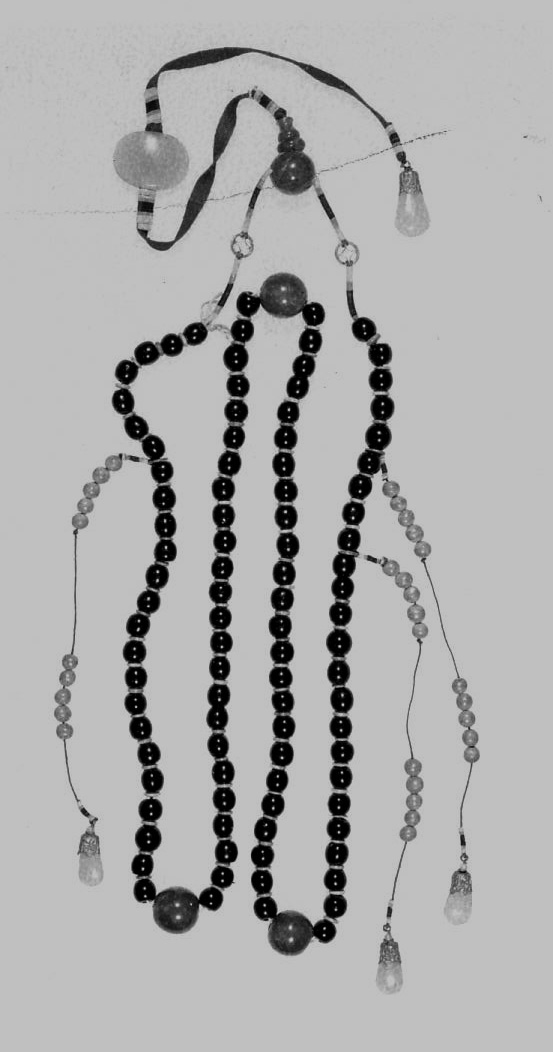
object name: necklace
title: Court necklace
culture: chinese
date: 1701-1900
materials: glass, silk